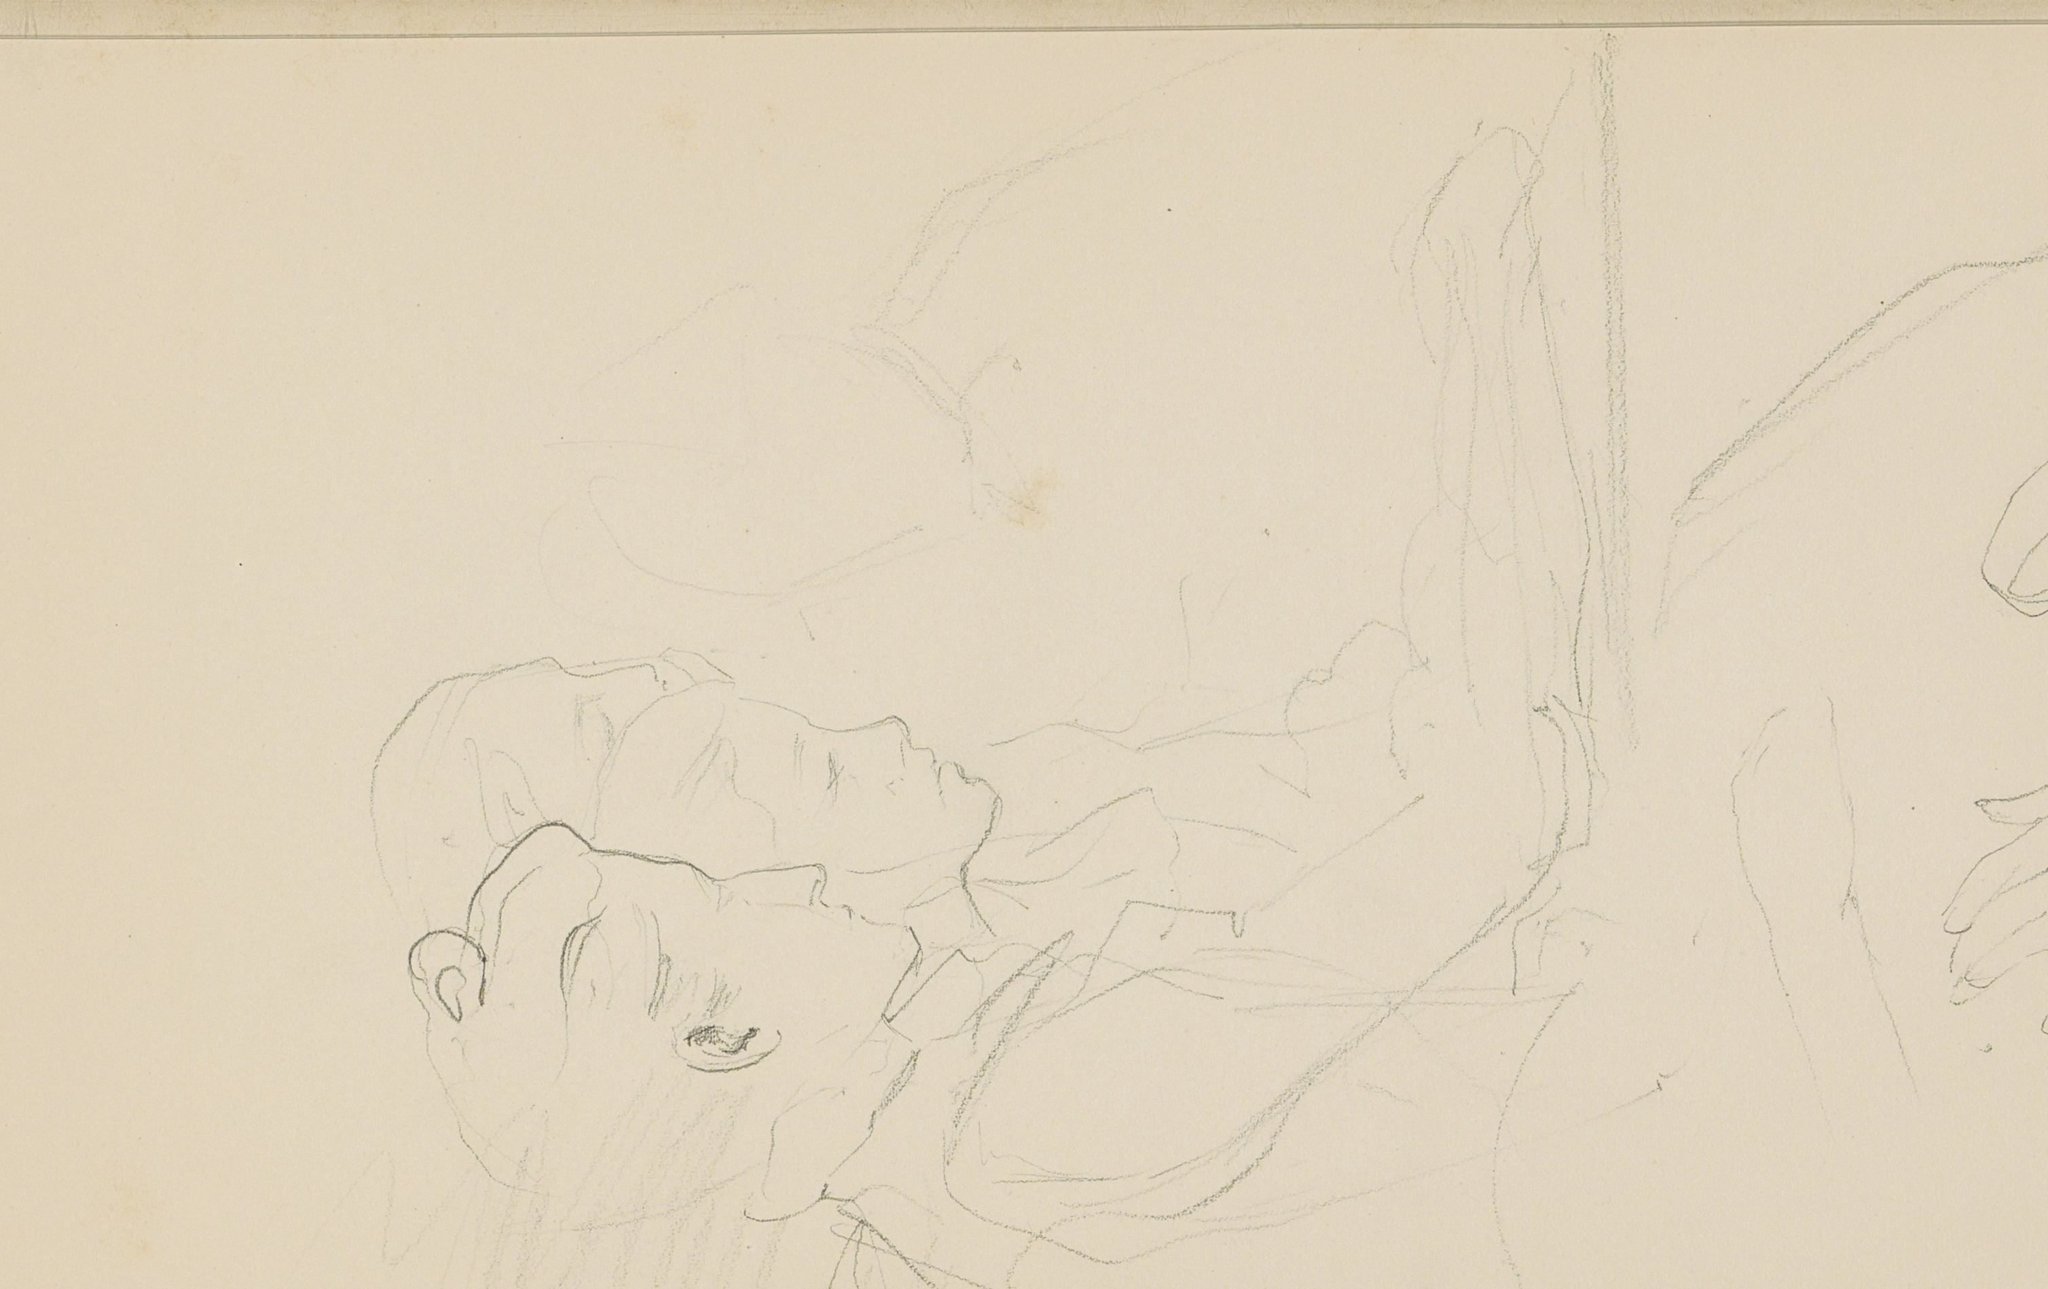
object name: sketchbook leaf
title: Groep figuren aan een tafel, mogelijk een tekentafel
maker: a.a.l. de grammont-hubrecht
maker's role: draughtsman, painter, print maker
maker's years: 1855-1913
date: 1865-1913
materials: chalk, paper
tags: sitting figure, adult woman, hand, table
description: Mogelijk volgen de figuren, vermoedelijk allen vrouw, een tekenles. Tevens een studie van een hand. Blad 24 recto uit een schetsboek met 65 bladen.